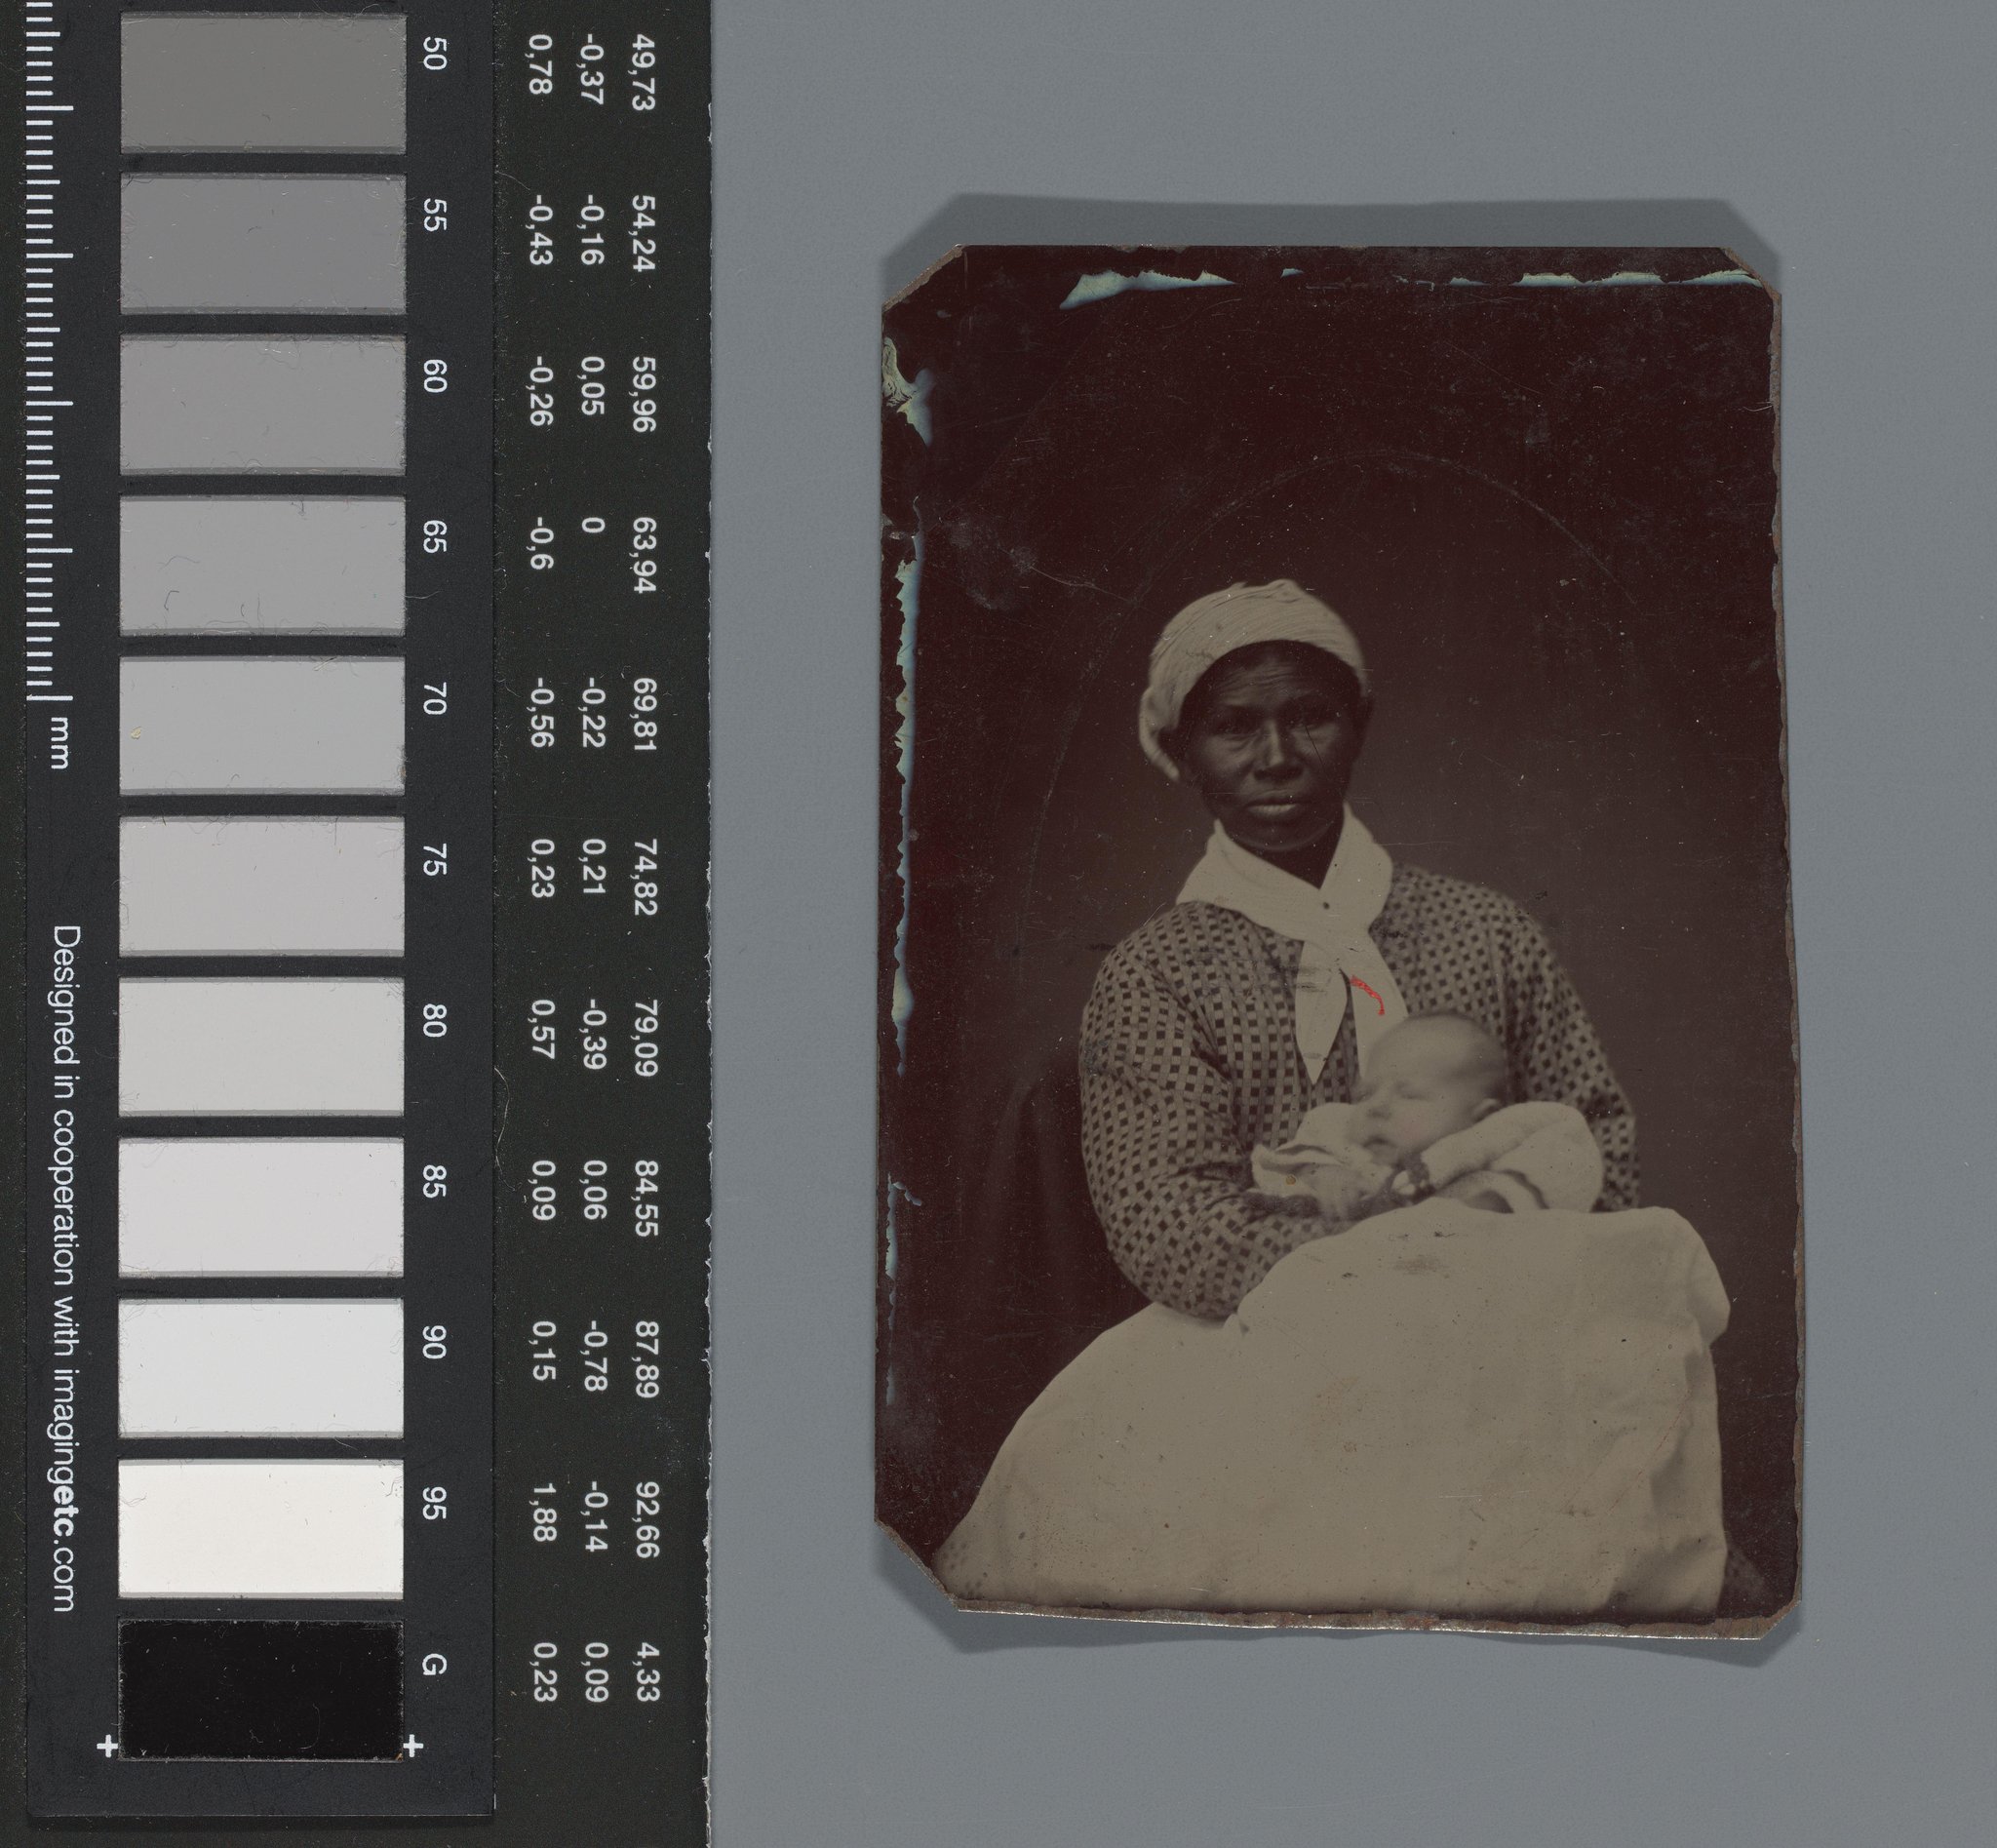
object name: photobook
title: Vrouw met baby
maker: Anonymous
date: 1870-1910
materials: photographic support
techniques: ferrotyping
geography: united states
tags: united states of america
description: Zittende zwarte vrouw met doek om haar hoofd en op schoot een witte baby.